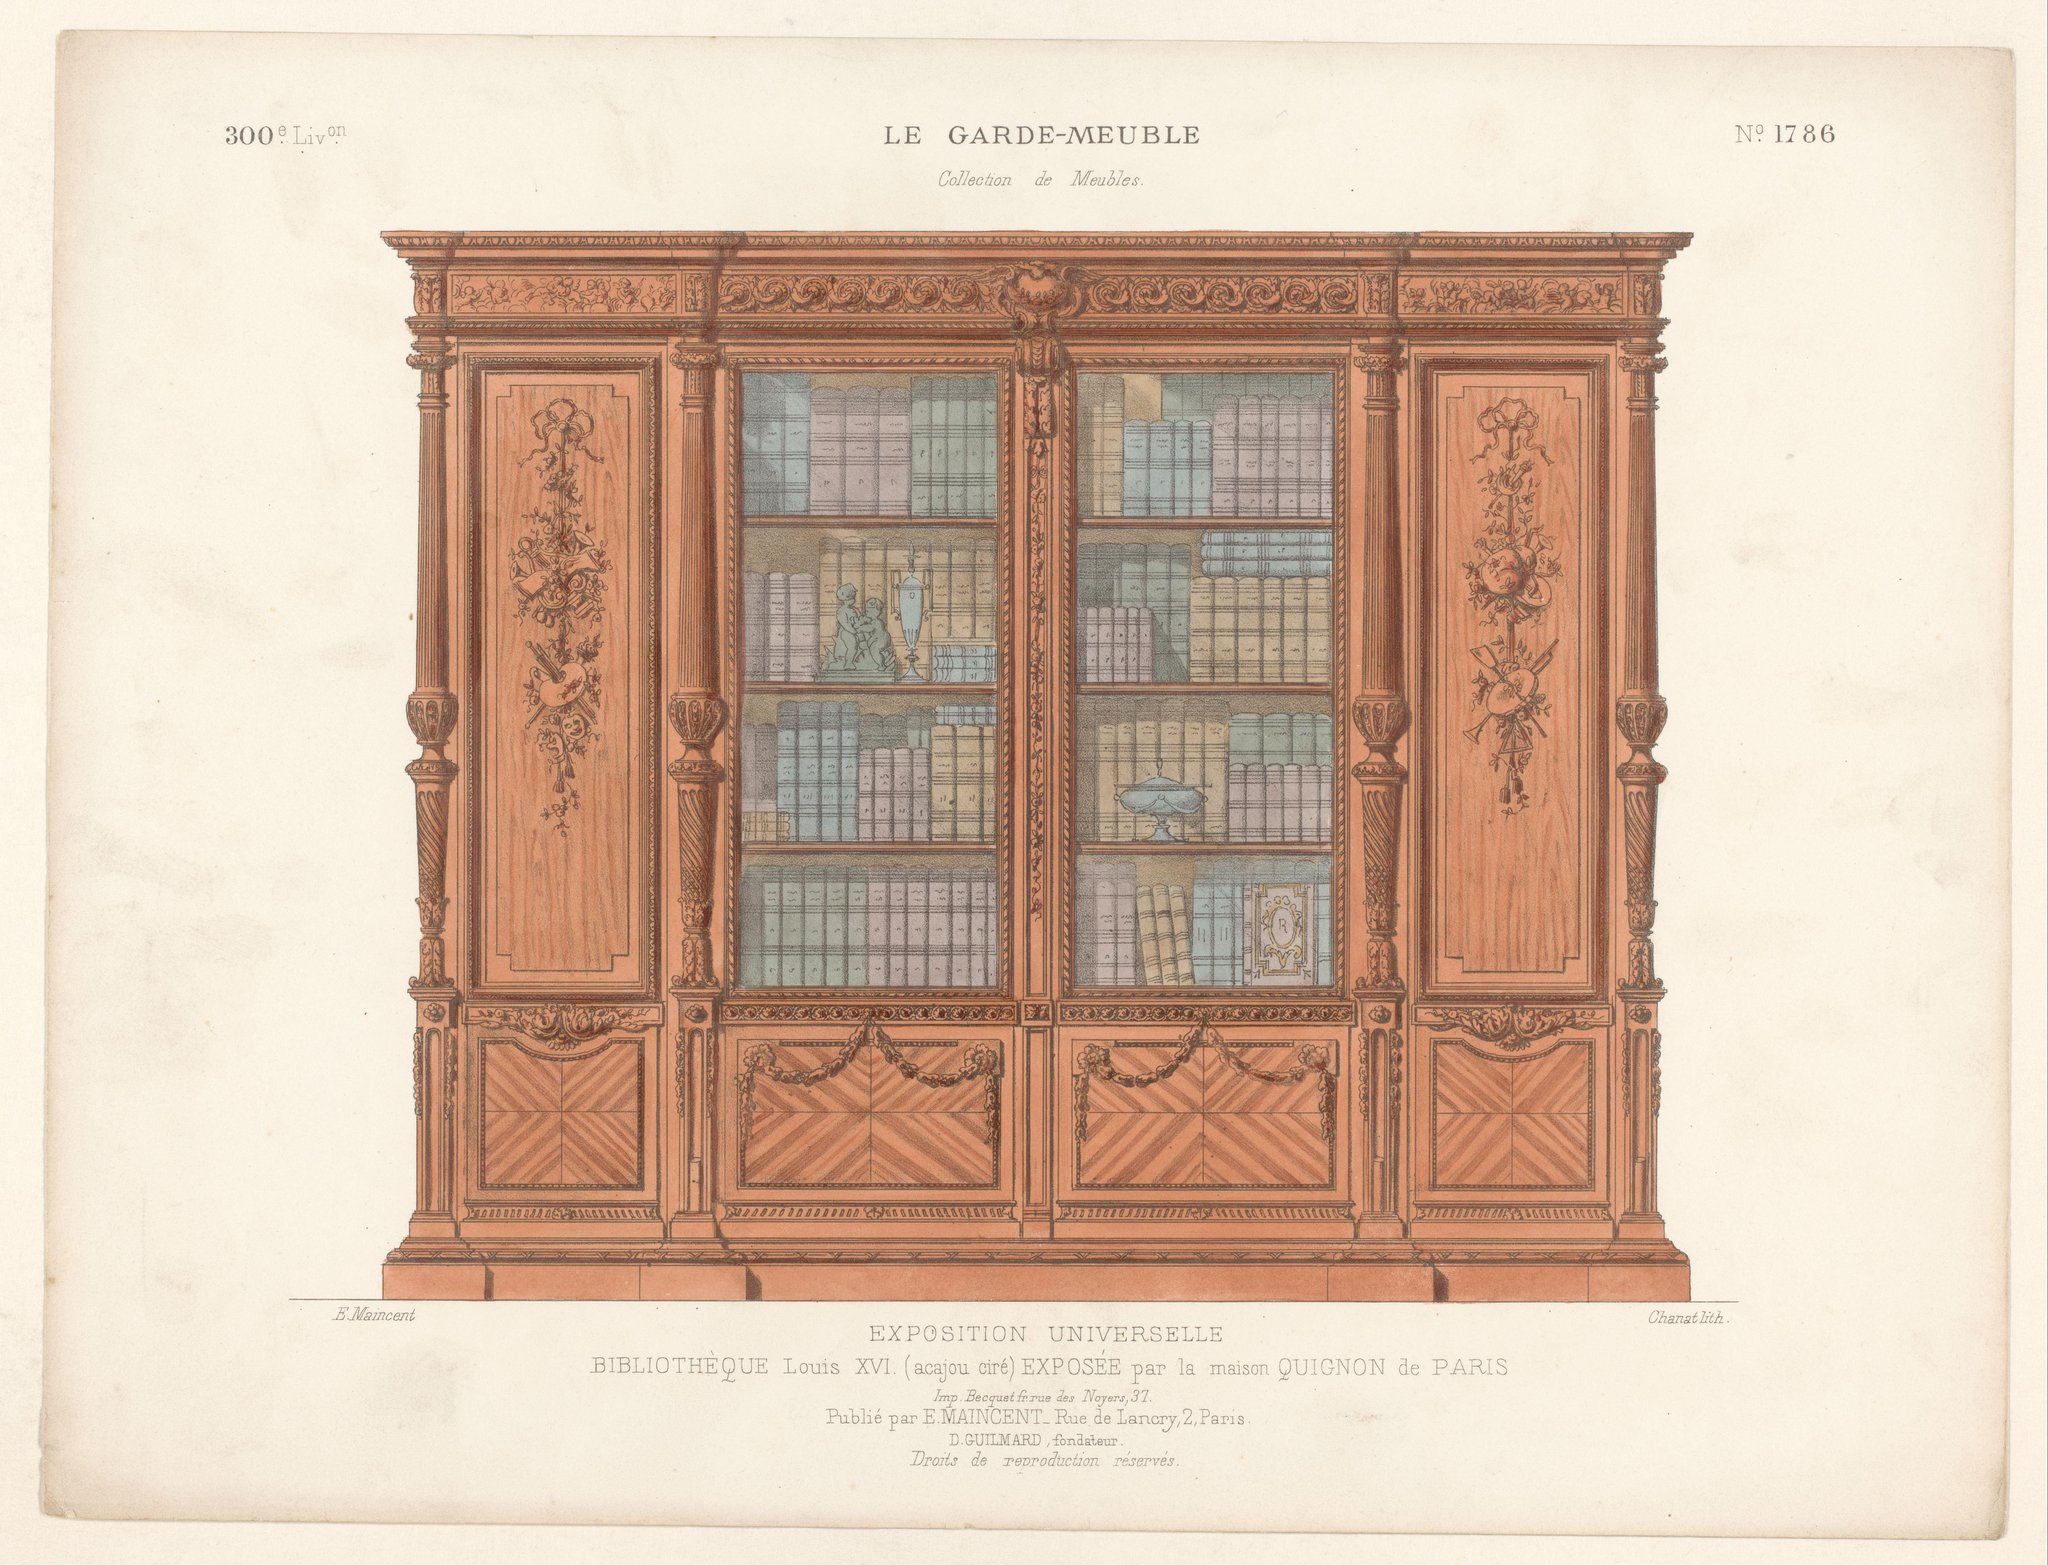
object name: print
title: Exposition universelle bibliothèque Louis XVI. (acajou ciré) exposée par la maison Quignon de Paris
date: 1885-1895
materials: paper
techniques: hand coloring, lithograph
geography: paris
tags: bookcase, with doors, paris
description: Ieder Livraison in de serie Le Garde-Meuble bevat negen platen: drie 'sièges' (zitmeubels), drie 'meubles' (diverse meubels zoals tafels en kasten) en drie 'tentures' (gordijnen en draperieën).